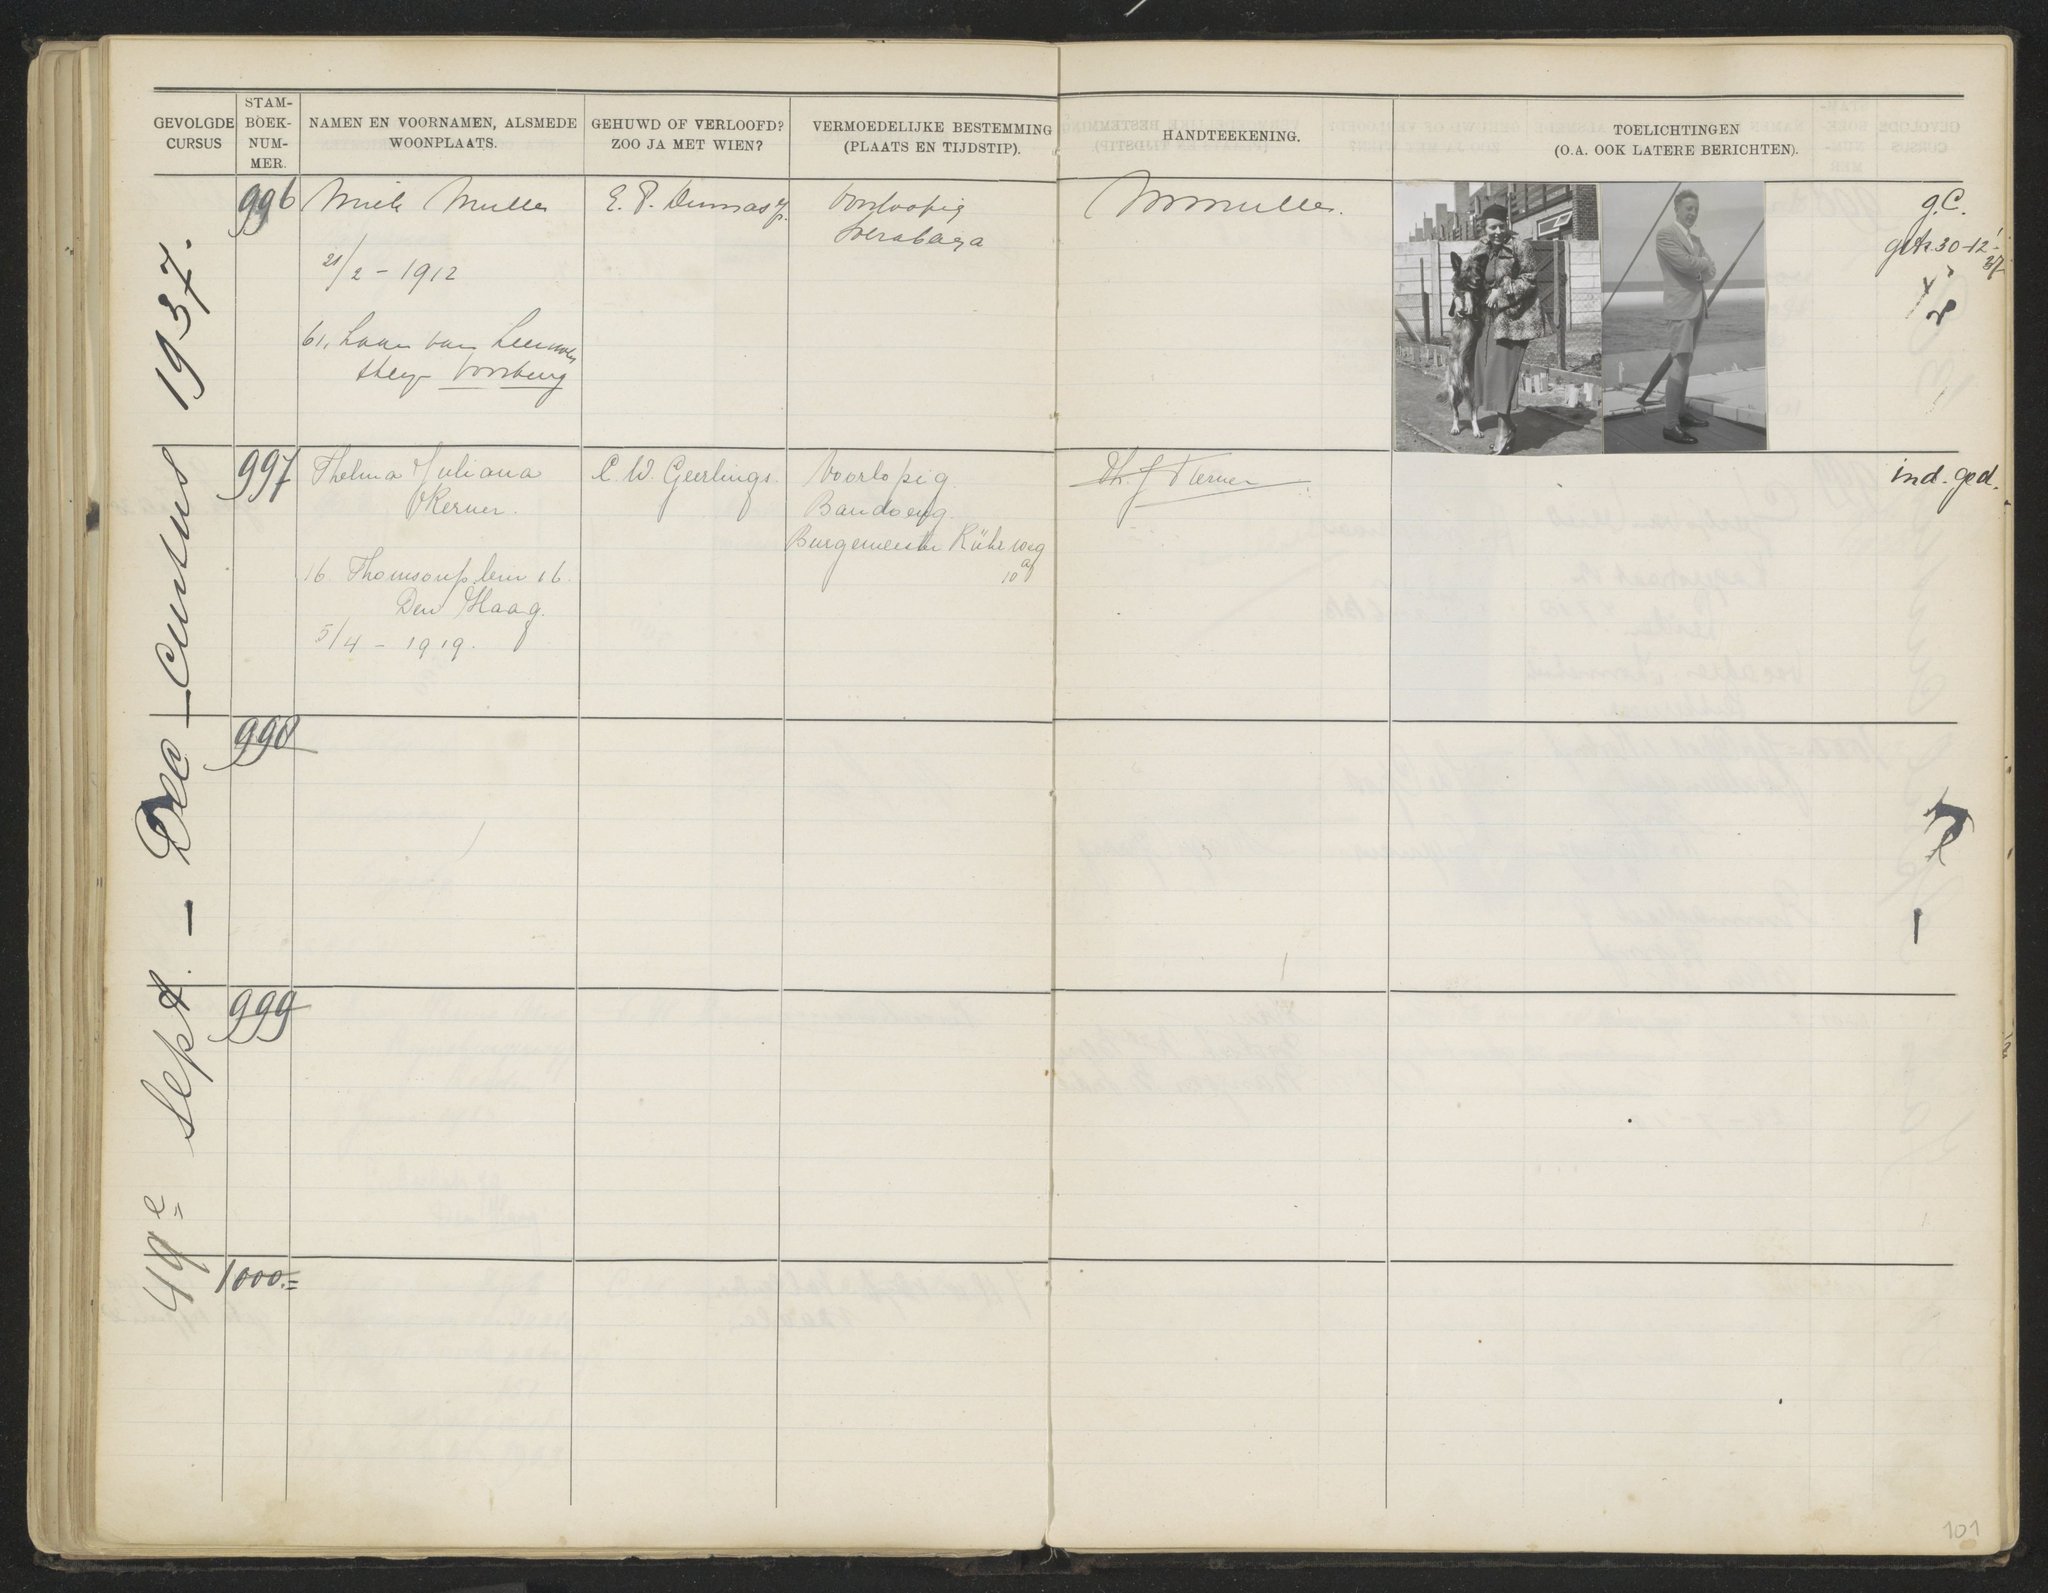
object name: photograph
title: Blad 101 uit Stamboek van de leerlingen der Koloniale School voor Meisjes en Vrouwen te 's-Gravenhage deel II (1930-1949)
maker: Anonymous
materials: paper, photographic support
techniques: photography, printing, writing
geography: the hague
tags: further education (+ pupil), further education, the hague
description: Twee pagina's met gegevens van de deelnemers aan de 49e driemaandelijkse cursus van september tot december 1937, stamboeknummers 996 tot en met 997. Onderdeel van Stamboek van de leerlingen der Koloniale School voor Meisjes en Vrouwen te 's-Gravenhage deel II (1930-1949).